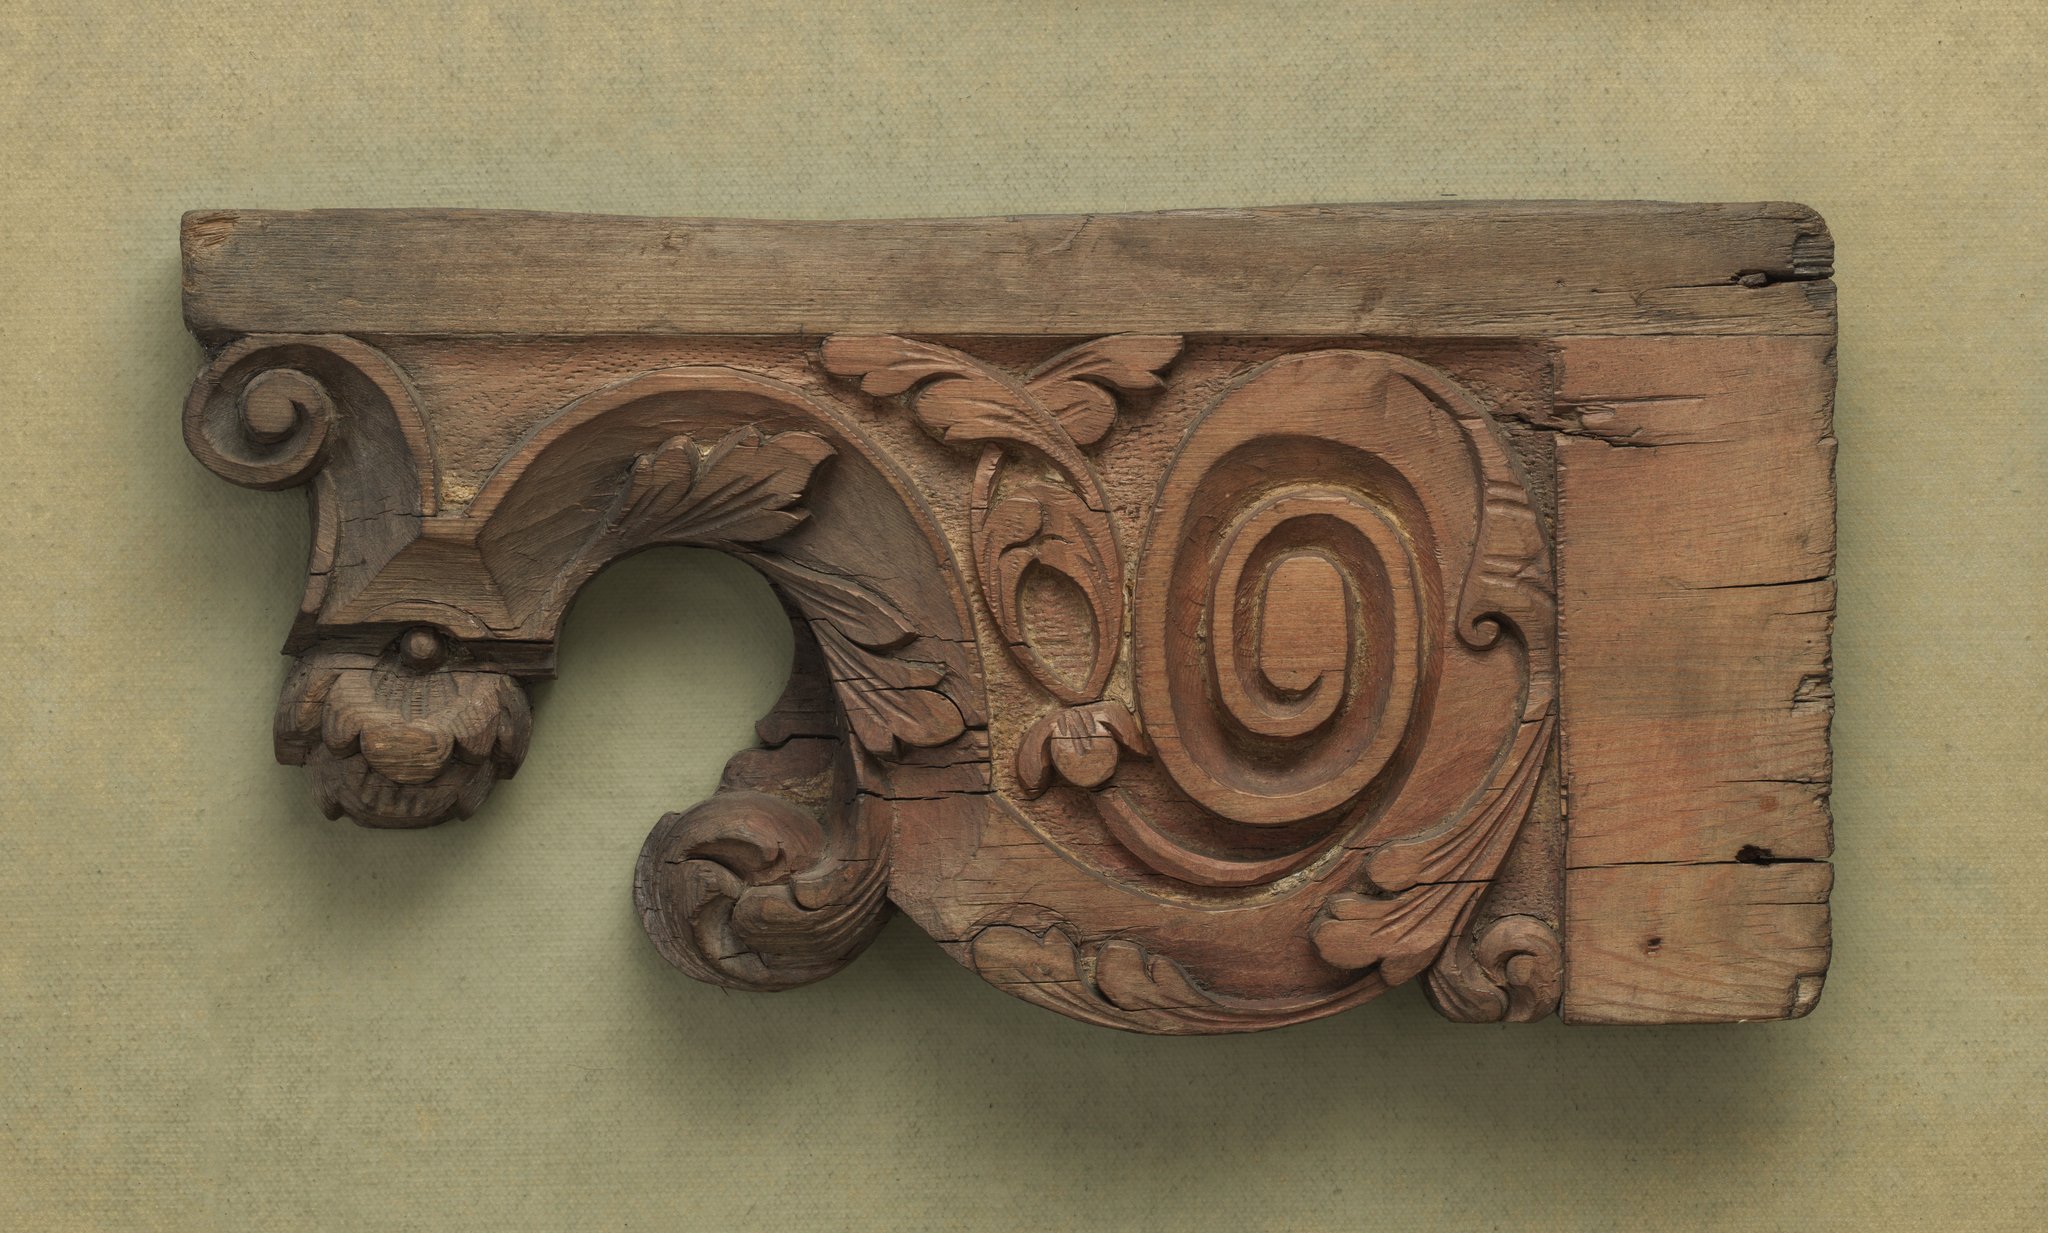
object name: bracket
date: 1701-1800